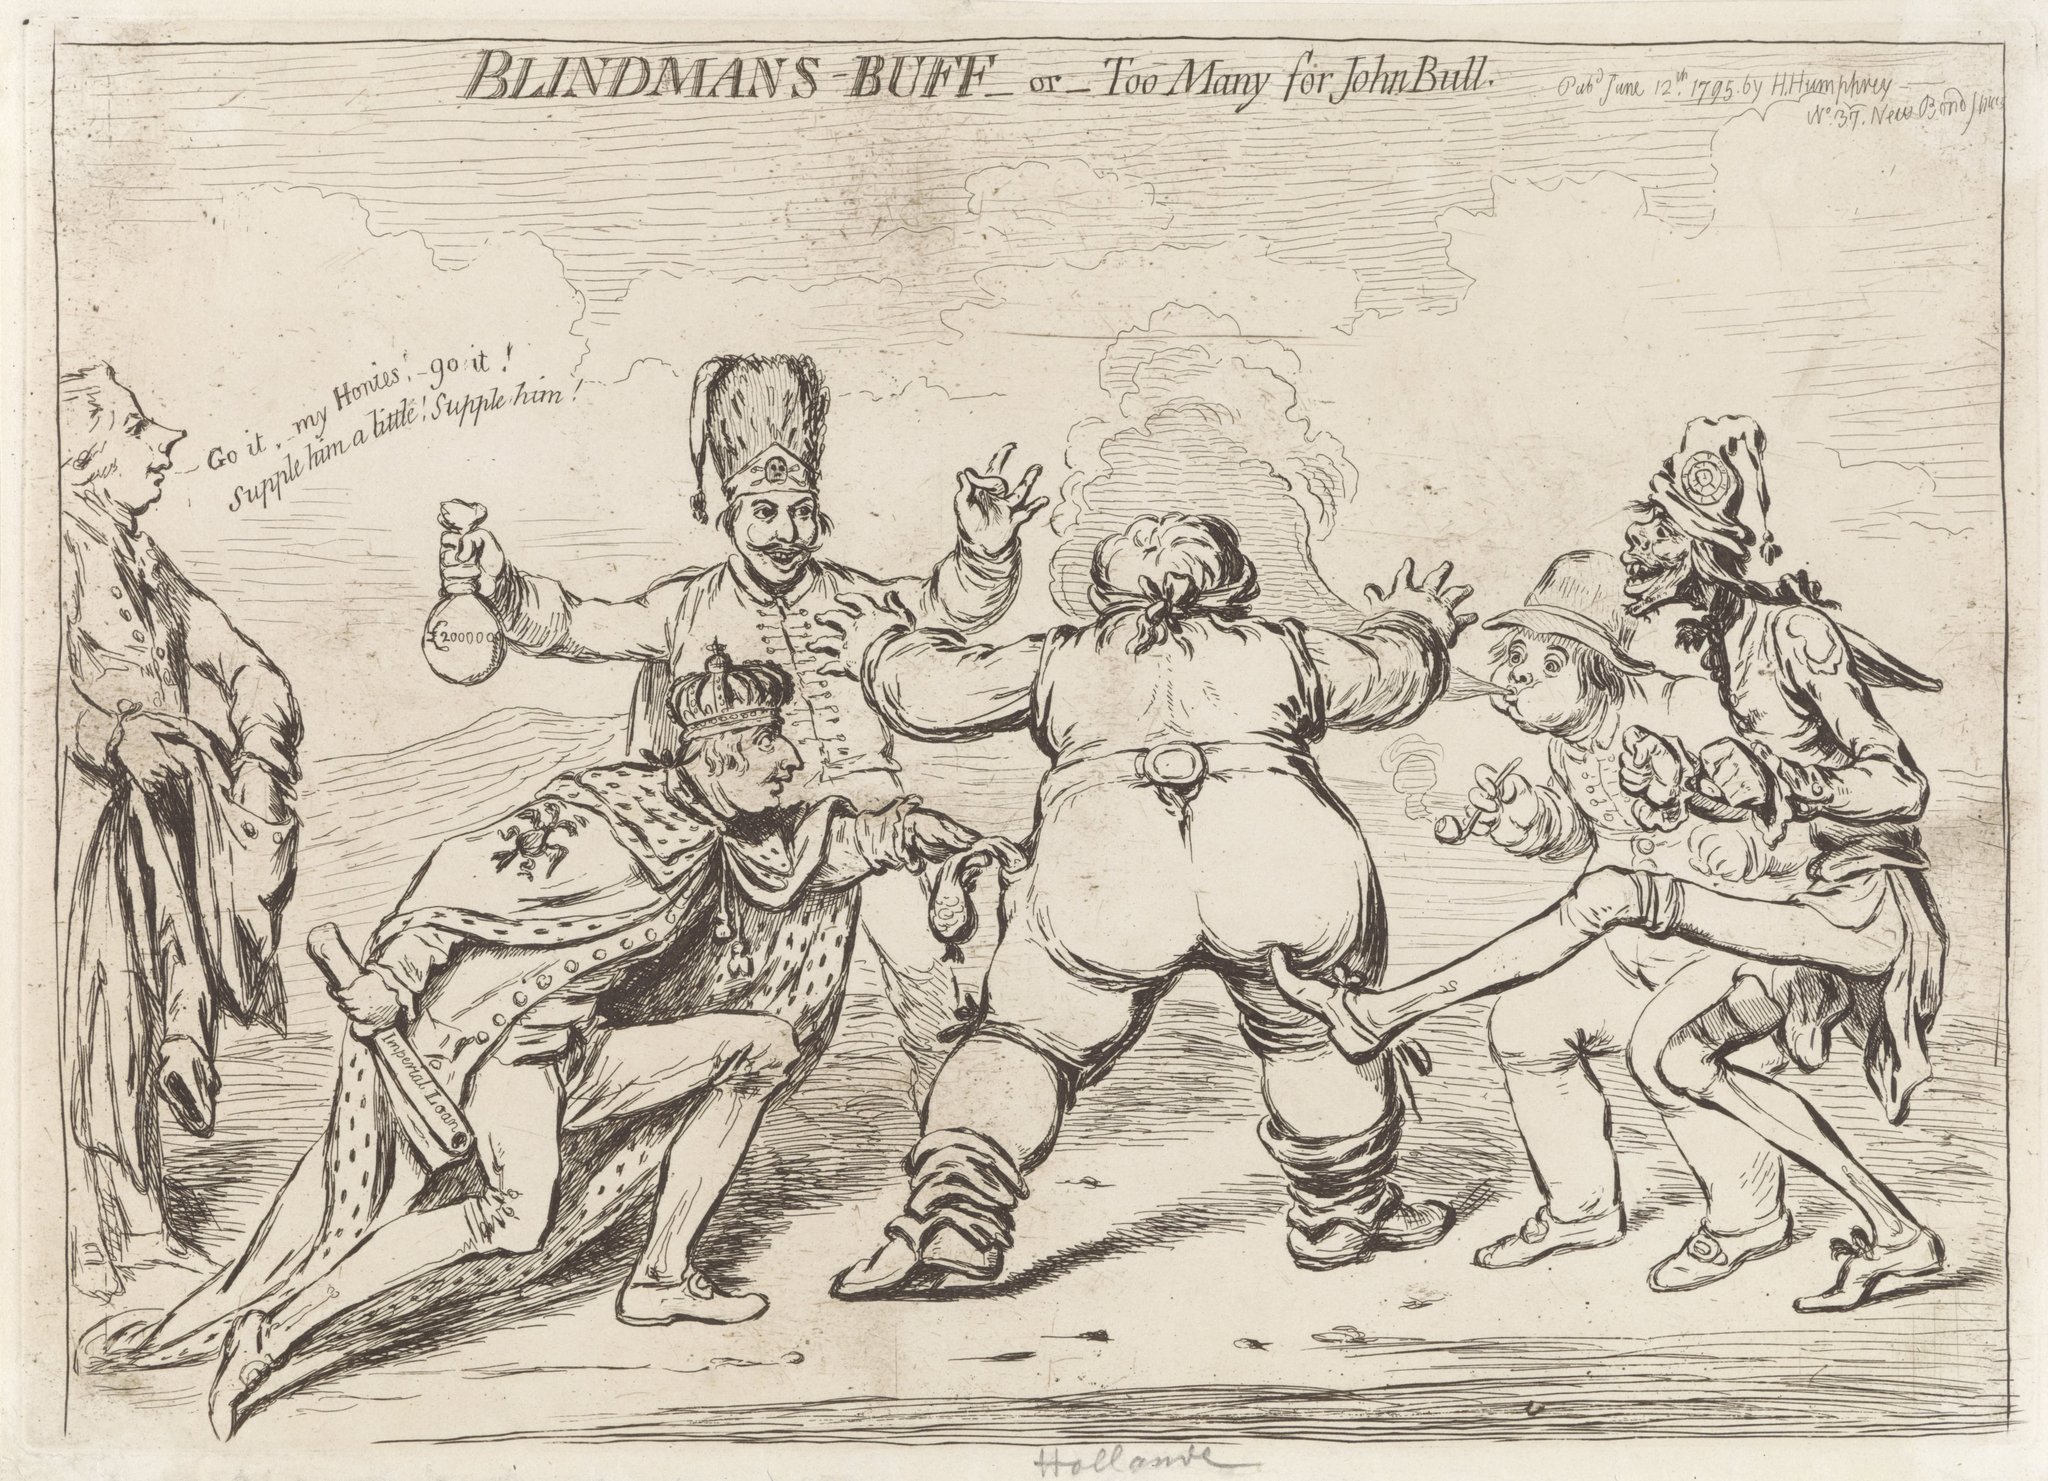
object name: print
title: John Bull te grazen genomen door de Europese machten, 1795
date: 1795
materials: paper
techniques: etching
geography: london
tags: vienna, frans ii (rooms-duits keizer), blind-man's buff, personifications of countries, nations, states, districts, etc., alliance with france (1795)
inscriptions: collector's mark: Lugt 2228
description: Spotprent waarin John Bull (Groot-Brittannië) tijdens het spel blindemannetje te grazen genomen wordt door de andere Europese machten, juni 1795. Aan de linkerzijde wordt hij beroofd door de Habsburgse keizer Frans II en de Pruisische huzaar, rechts krijgt hij op zijn achterste een trap van de Fransman terwijl de Hollander hem tabaksrook in het gezicht blaast. Links staat William Pitt die de partijen aanmoedigt.